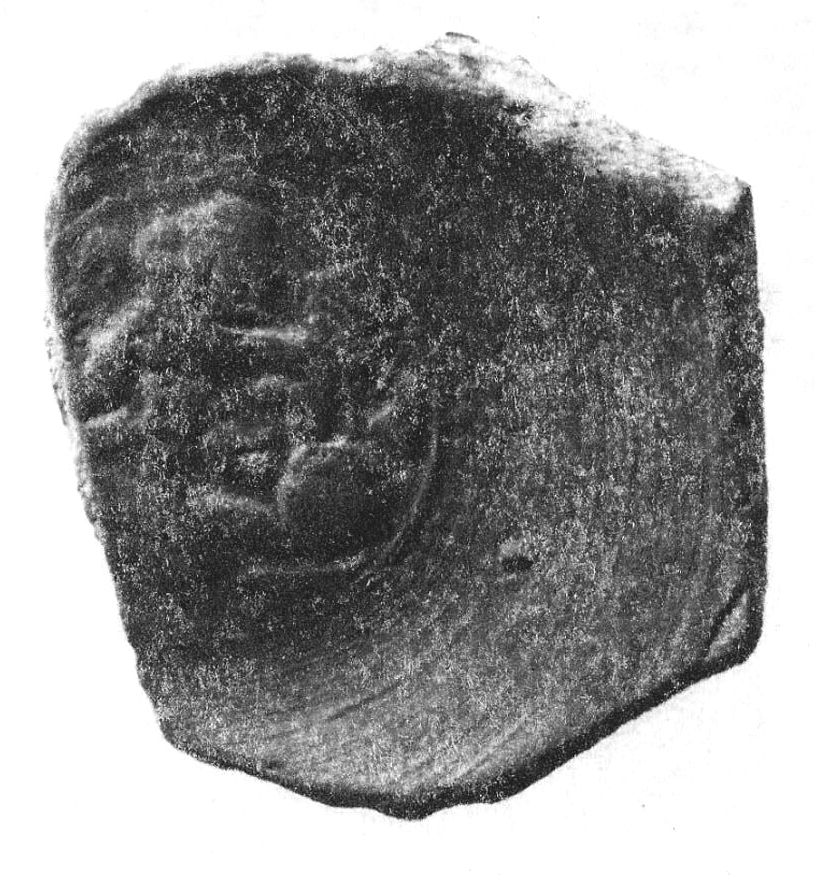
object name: fragment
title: Mithuna (Loving Couple) (Study Collection)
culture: kashmiri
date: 701-800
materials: terracotta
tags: kashmir